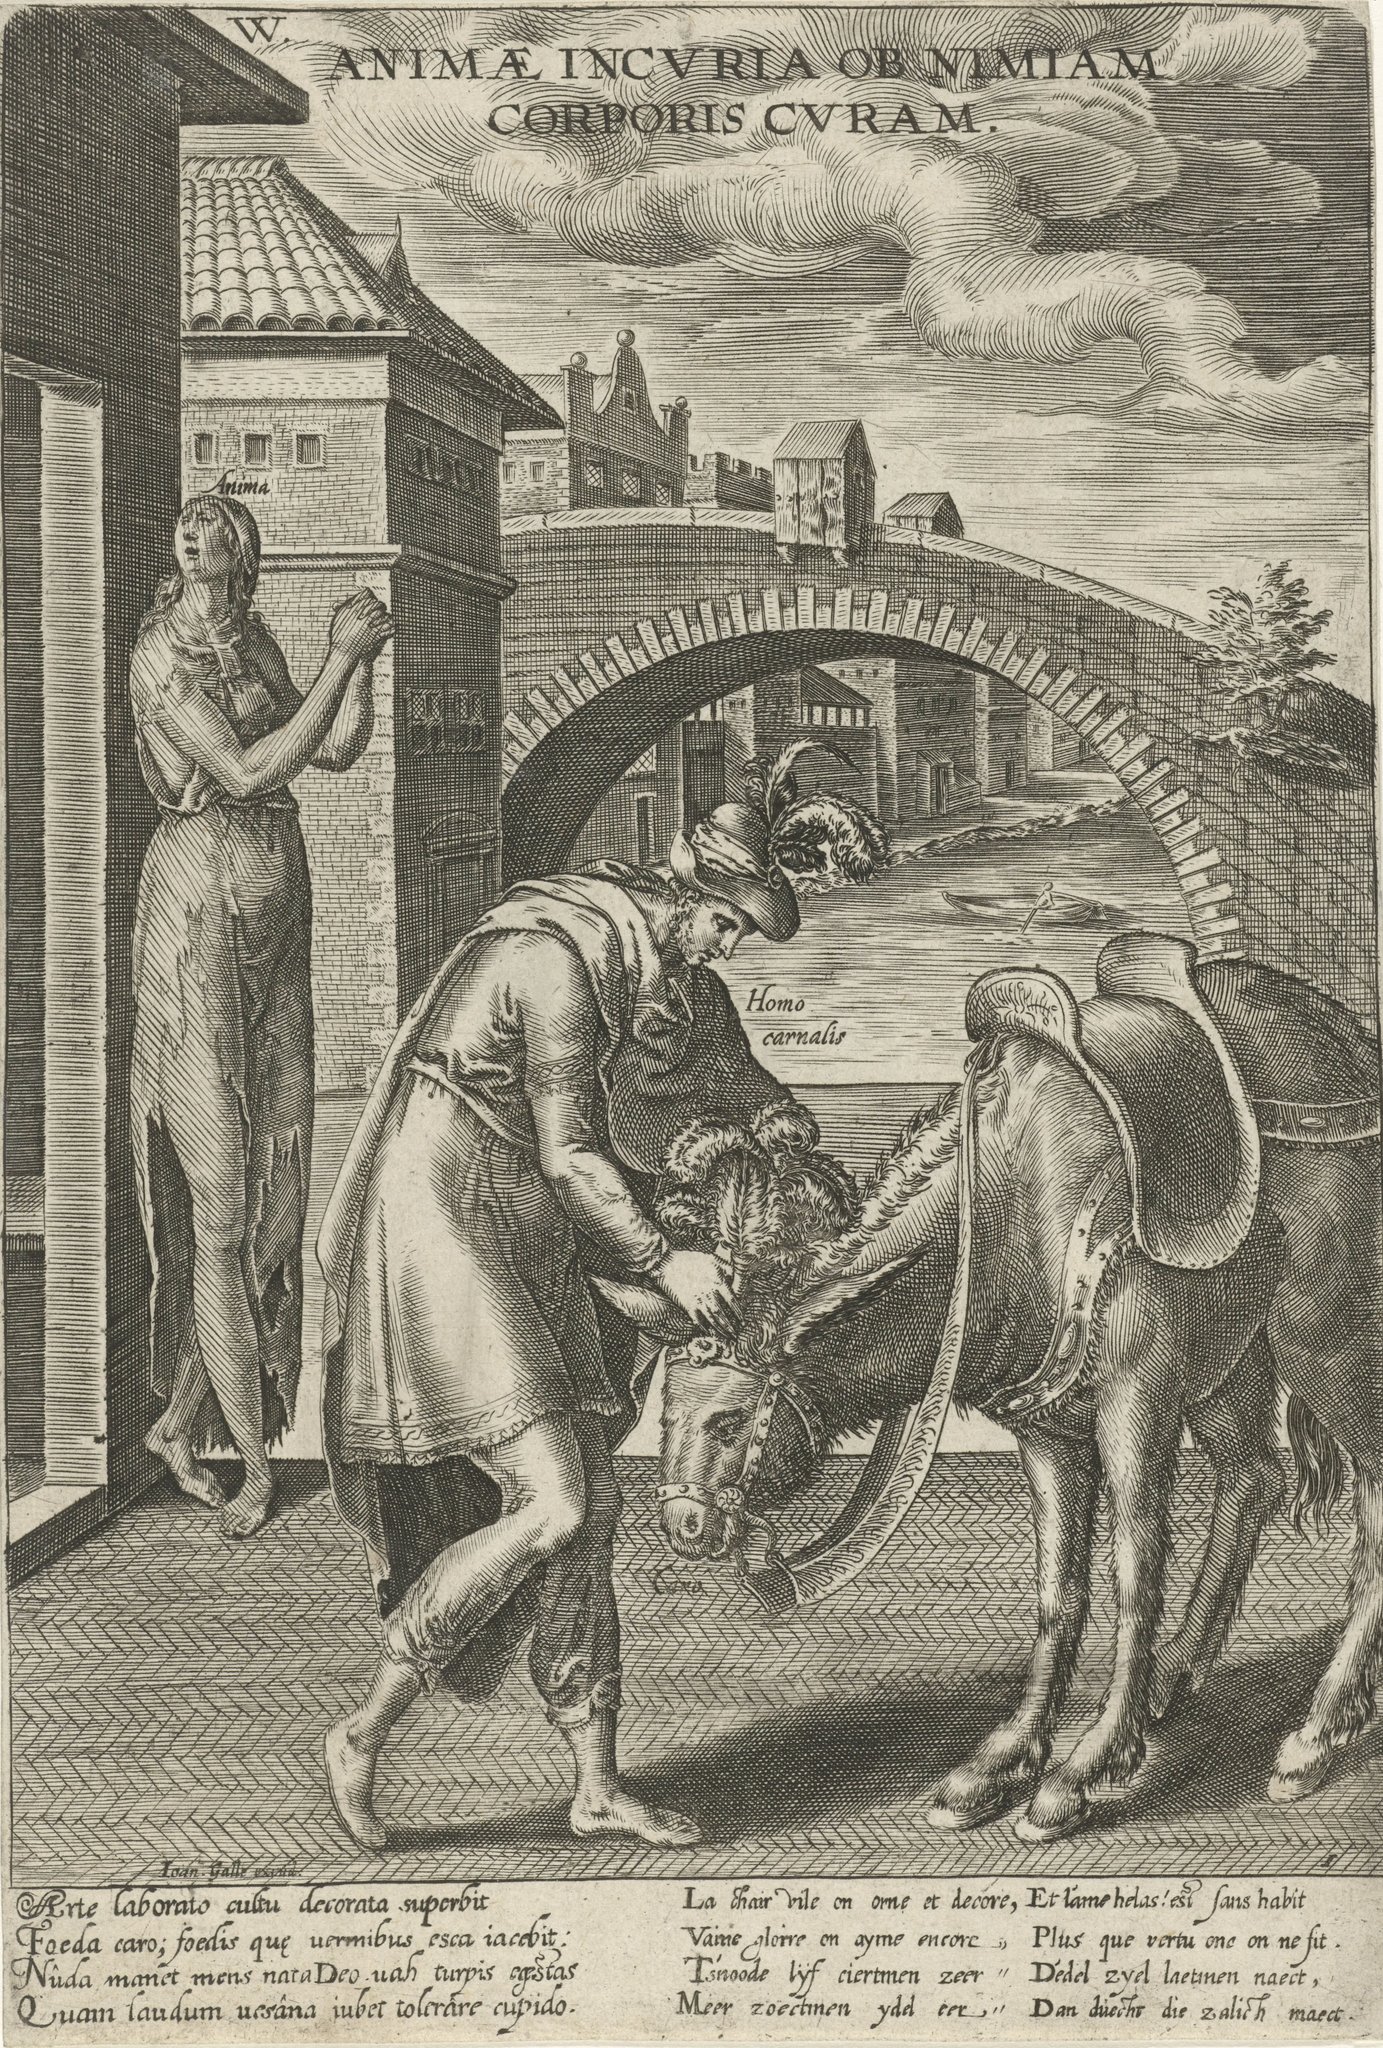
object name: print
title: Animae incvria ob nimiam corporis Cvram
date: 1610-1676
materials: paper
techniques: engraving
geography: antwerp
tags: lust, luxury, 'luxuria'; 'lussuria' (ripa) ~ personification of one of the deadly sins, (personifications of) 'vanitas', the vanity of human life; fragilità humana, fugacità delle grandezze & della gloria mondana, meditatione della morte, opera vana, piacere vano, vana gloria, vanità (ripa), head-gear: hat (+ men's clothes), poverty; 'povertà', 'povertà del doni', 'povertà in uno ch'habbia bell'ingegno' (ripa), spirit (or soul) versus body, the soul during lifetime, ass, donkey (+ animals used symbolically)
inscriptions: collector's mark: Lugt 2228, signature: ‘W.’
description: De personificatie van de lustvolle mens (Homo Carnalis) kroont een ezel met een prachtige hoofdtooi. Deze ezel staat symbool voor zijn lichaam (Caro). Achter hem op een straathoek staat een armoedig geklede vrouw, de personificatie van de door de mens verwaarloosde ziel (Anima). Prent uit een serie van vier prenten over de zorg van de mens voor het lichaam en het negeren van de ziel. Elke prent met een onderschrift in het Latijn, Frans en Nederlands.